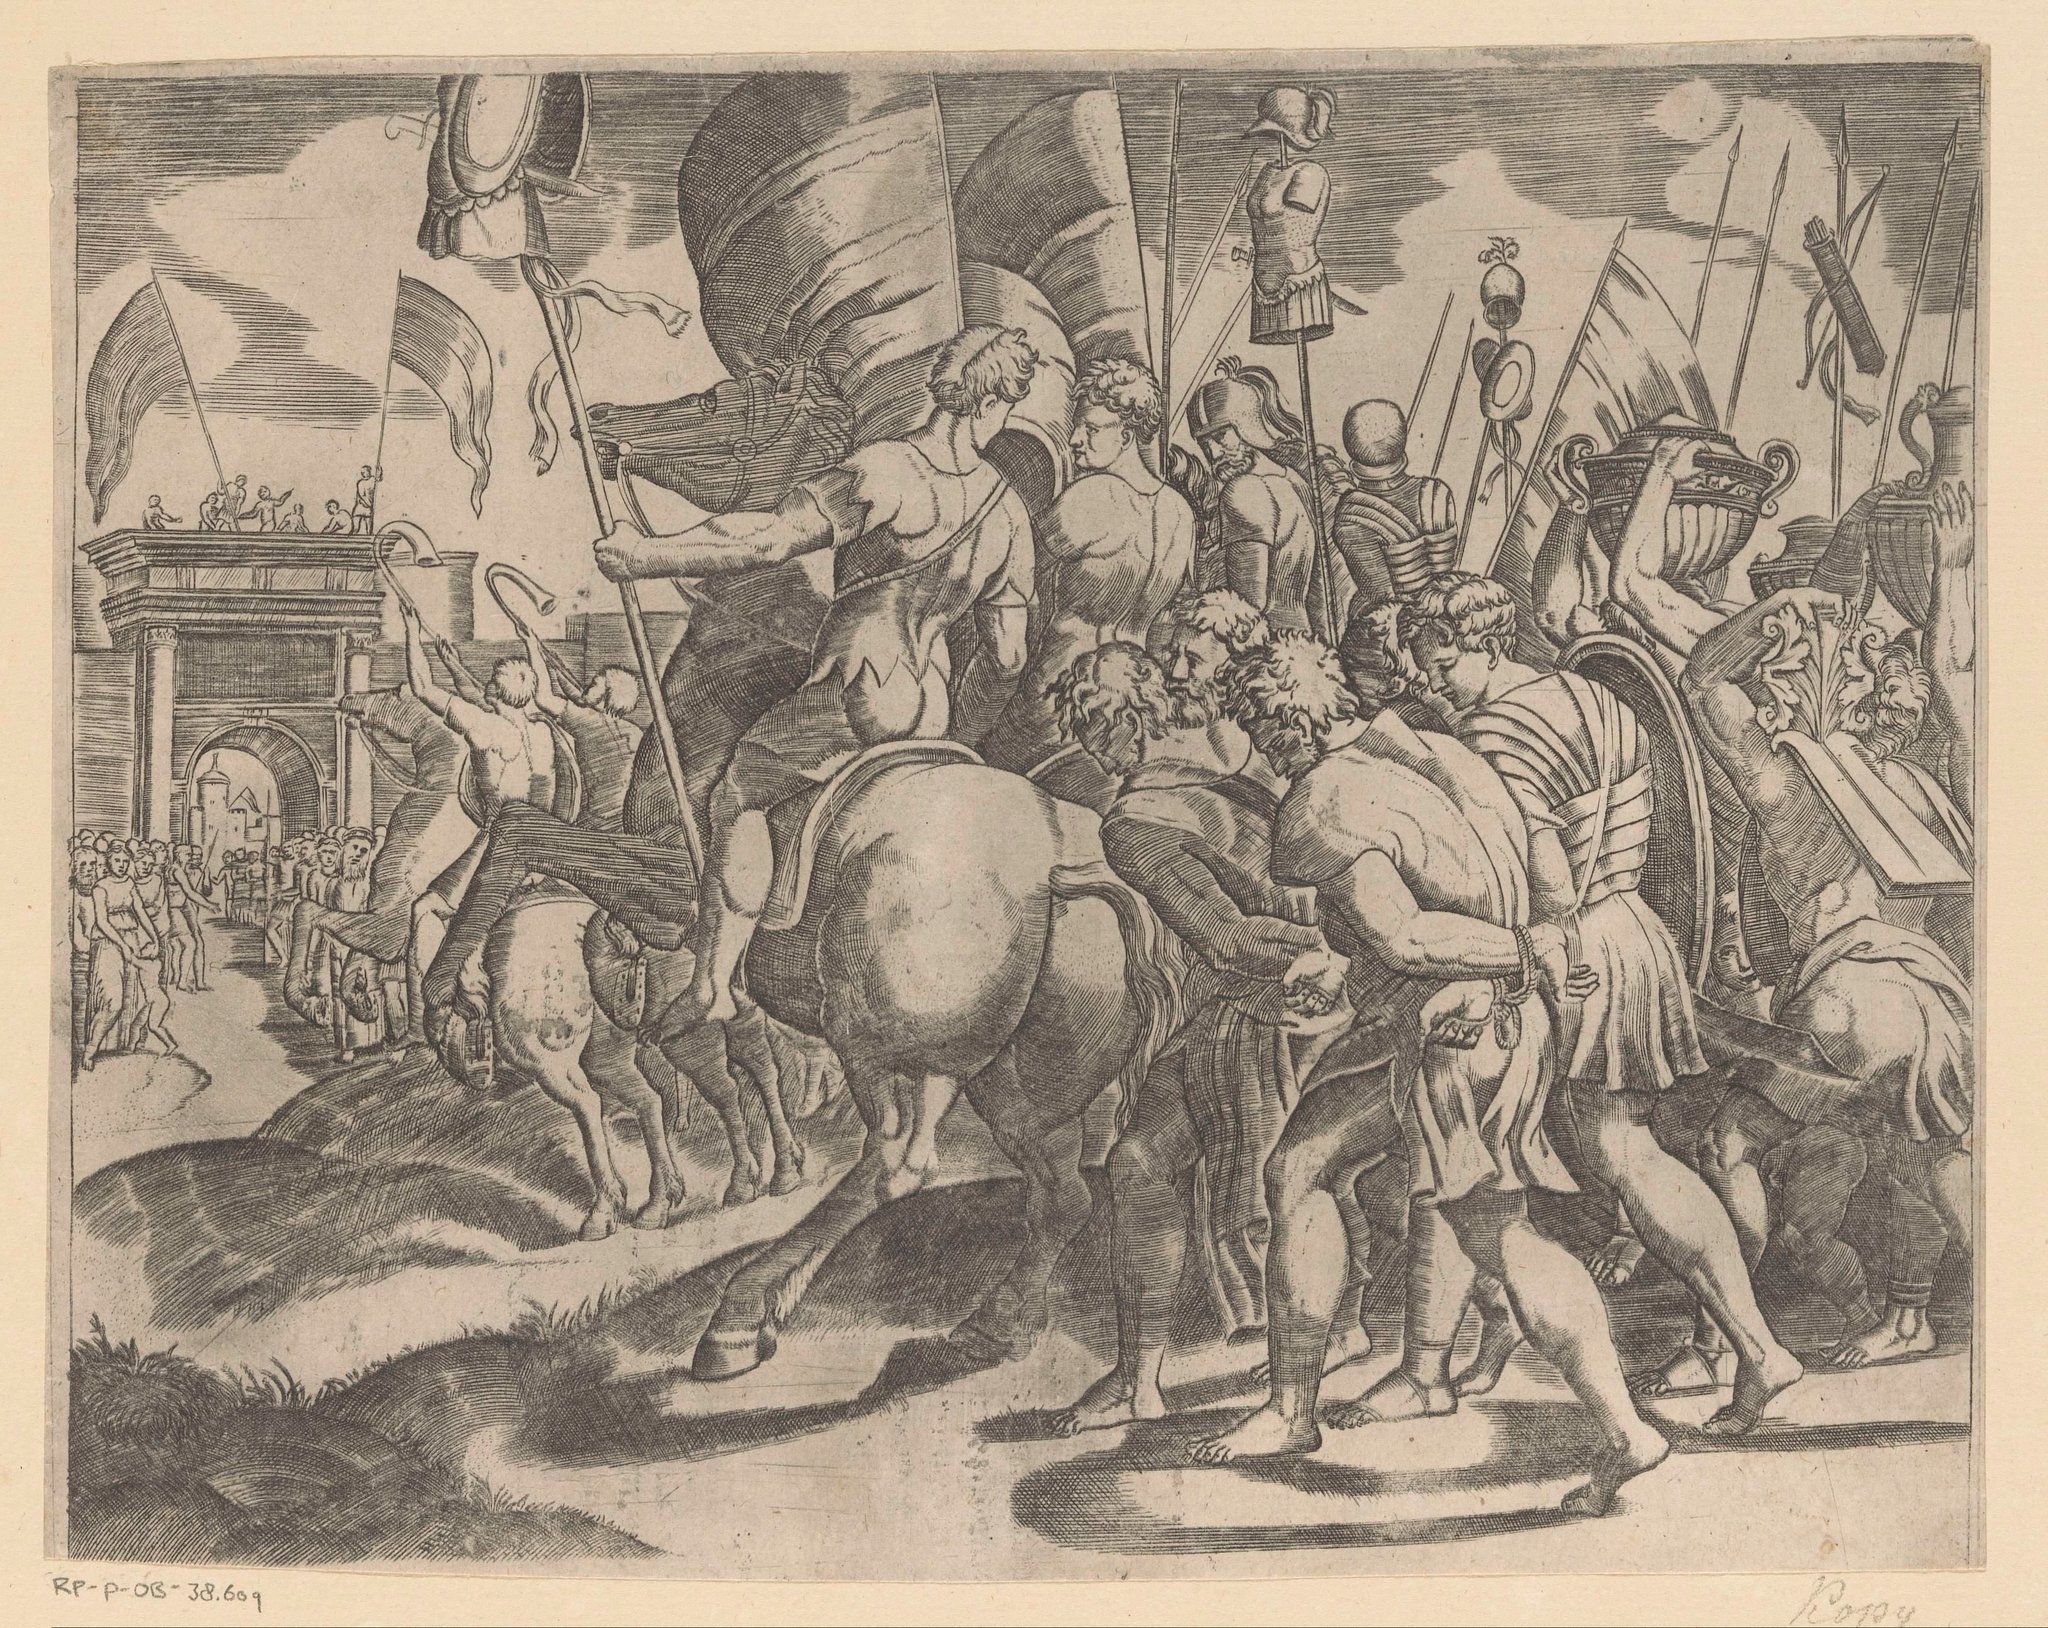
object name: print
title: Triomf van Scipio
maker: Anonymous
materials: paper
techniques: engraving, intaglio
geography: italy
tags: triumph of scipio, triumphal arch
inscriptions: collector's mark: Lugt 240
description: Triomfoptocht van Scipio Africanus in Rome na zijn overwinning op het Carthaagse leger. Achter de overwinnaars te paard lopen de geketende overwonnenen. Links een triomfboog.